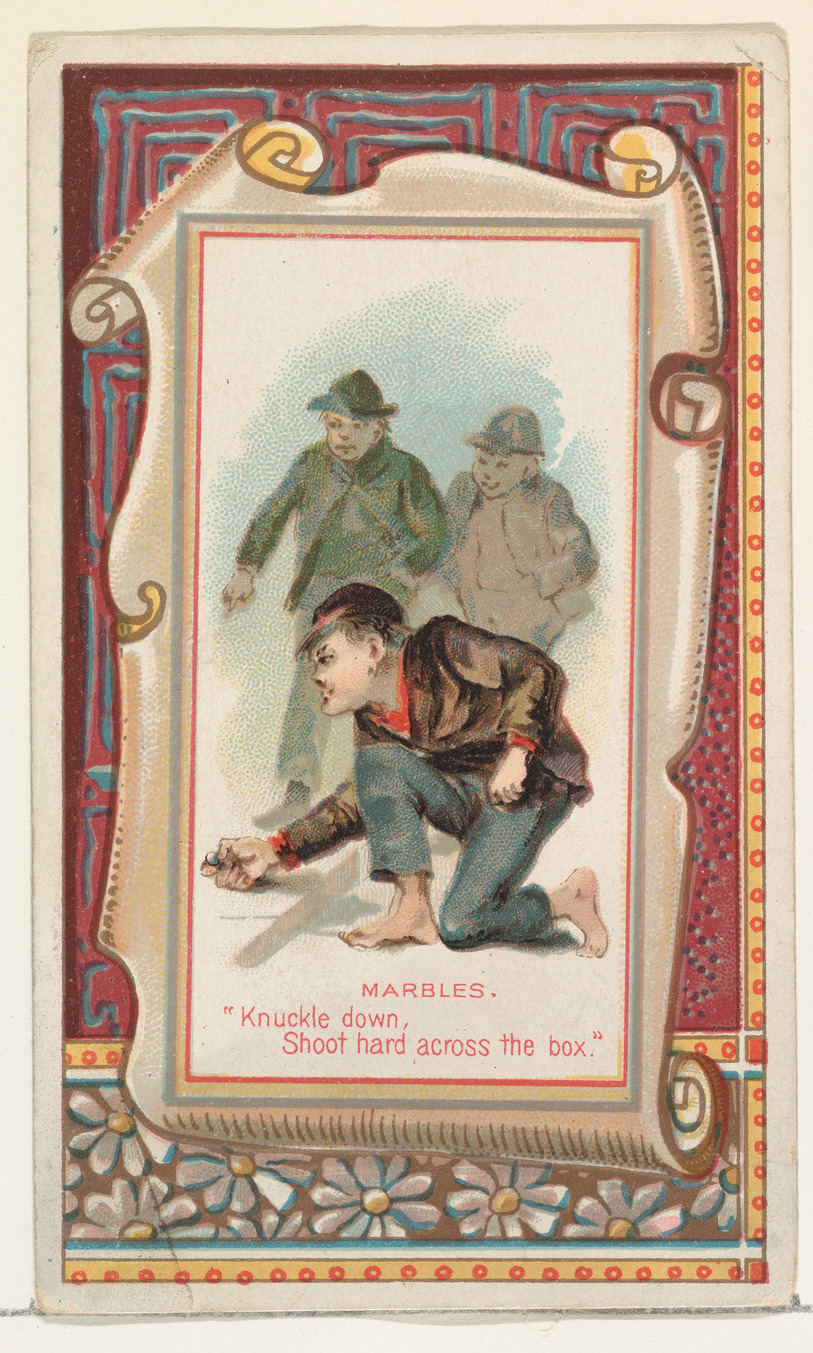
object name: print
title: Marbles, "Knuckle down, Shoot hard across the box," from the Terrors of America set (N136) issued by Duke Sons & Co. to promote Honest Long Cut Tobacco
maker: w. duke, sons & co.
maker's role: publisher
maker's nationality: american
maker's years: 1870-1920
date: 1888-1889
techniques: color lithograph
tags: boys,men